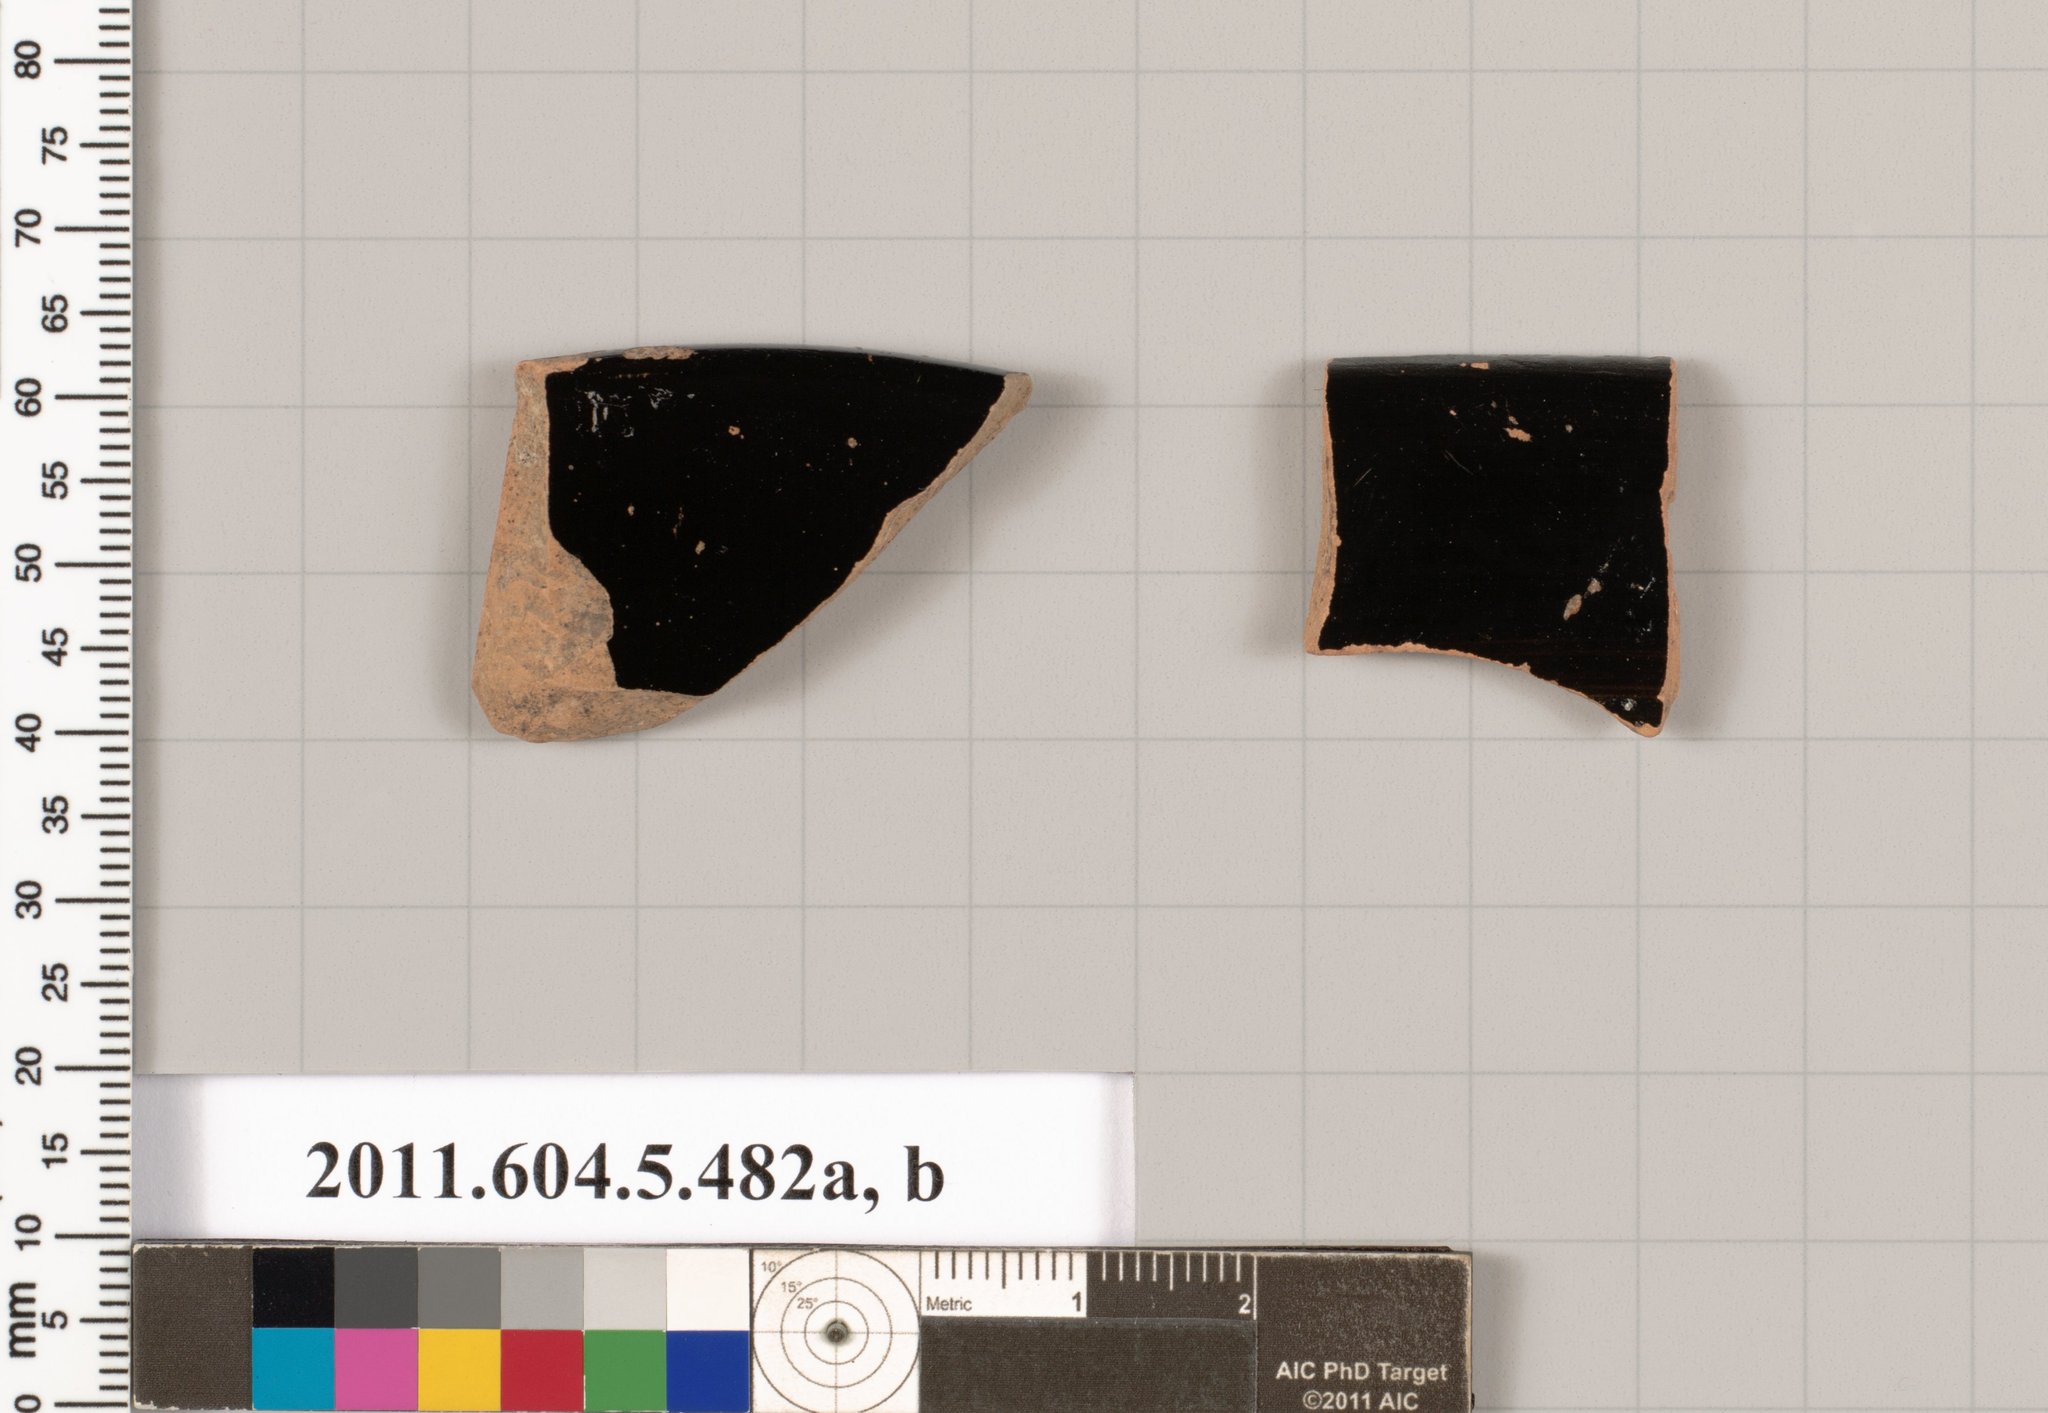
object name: kylix fragment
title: Terracotta rim fragments of kylikes (drinking cups)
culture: greek, attic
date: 600-401 BCE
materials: terracotta